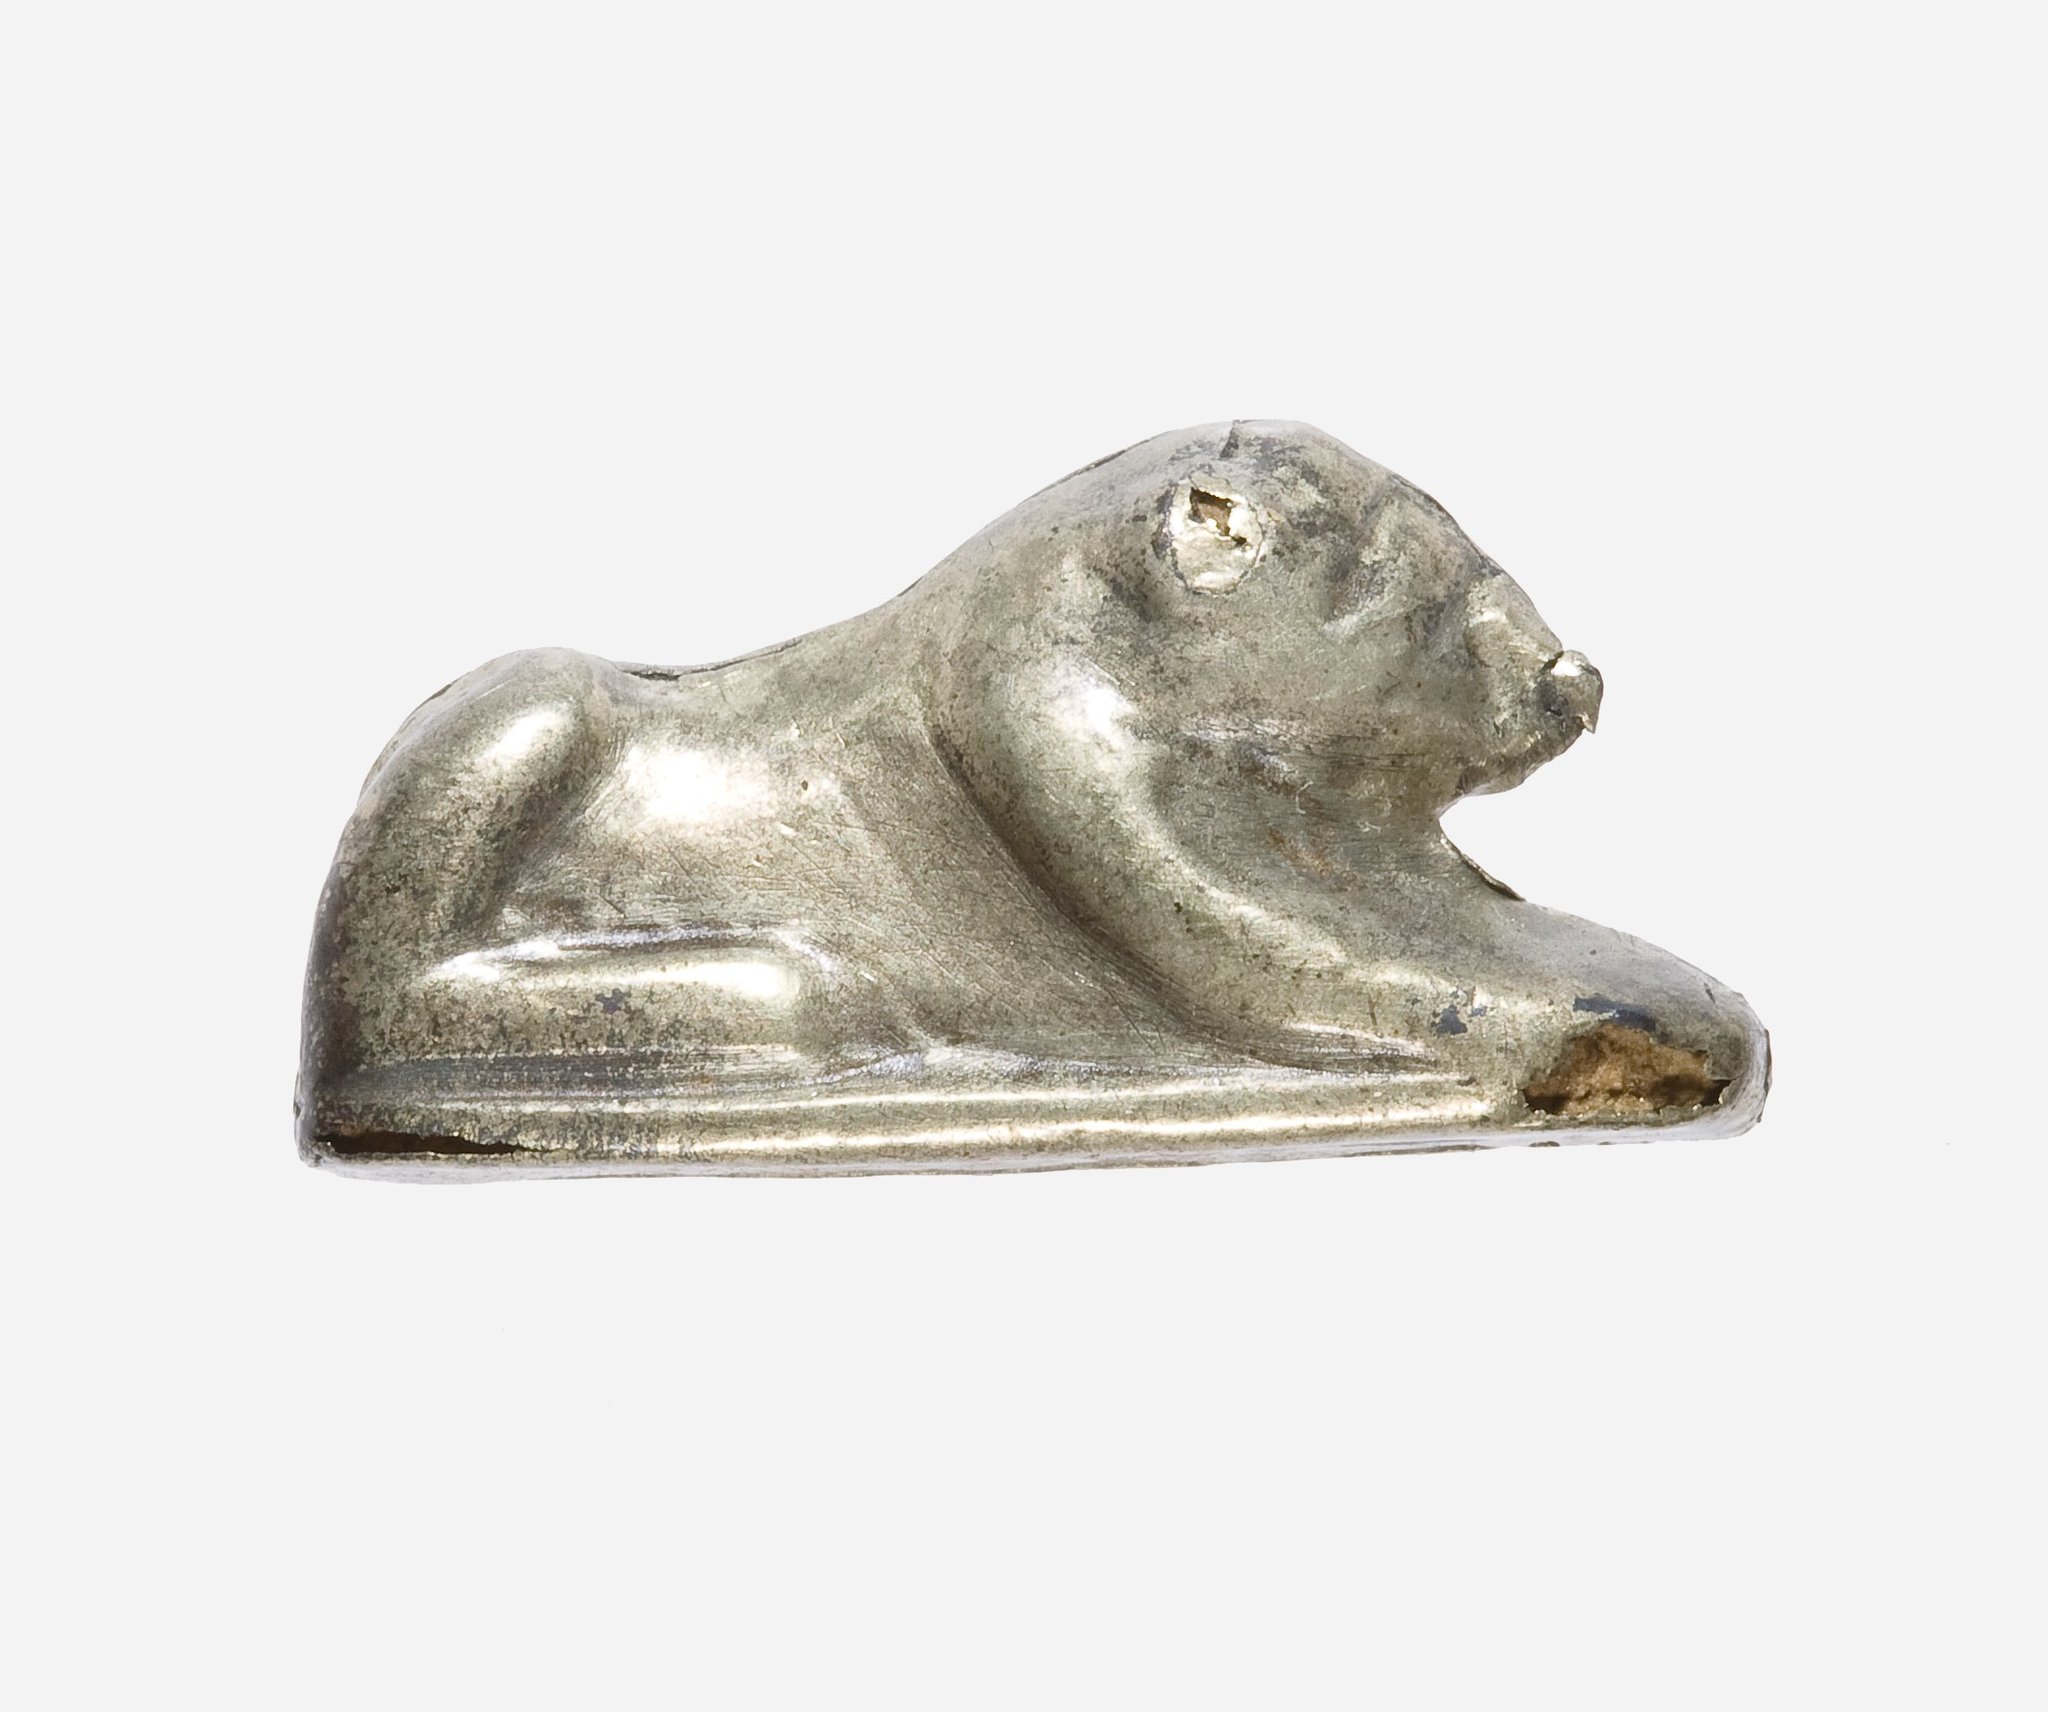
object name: amulet, lion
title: Lion Amulet from a Bracelet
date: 1850-1775 BCE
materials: silver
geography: egypt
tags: lions